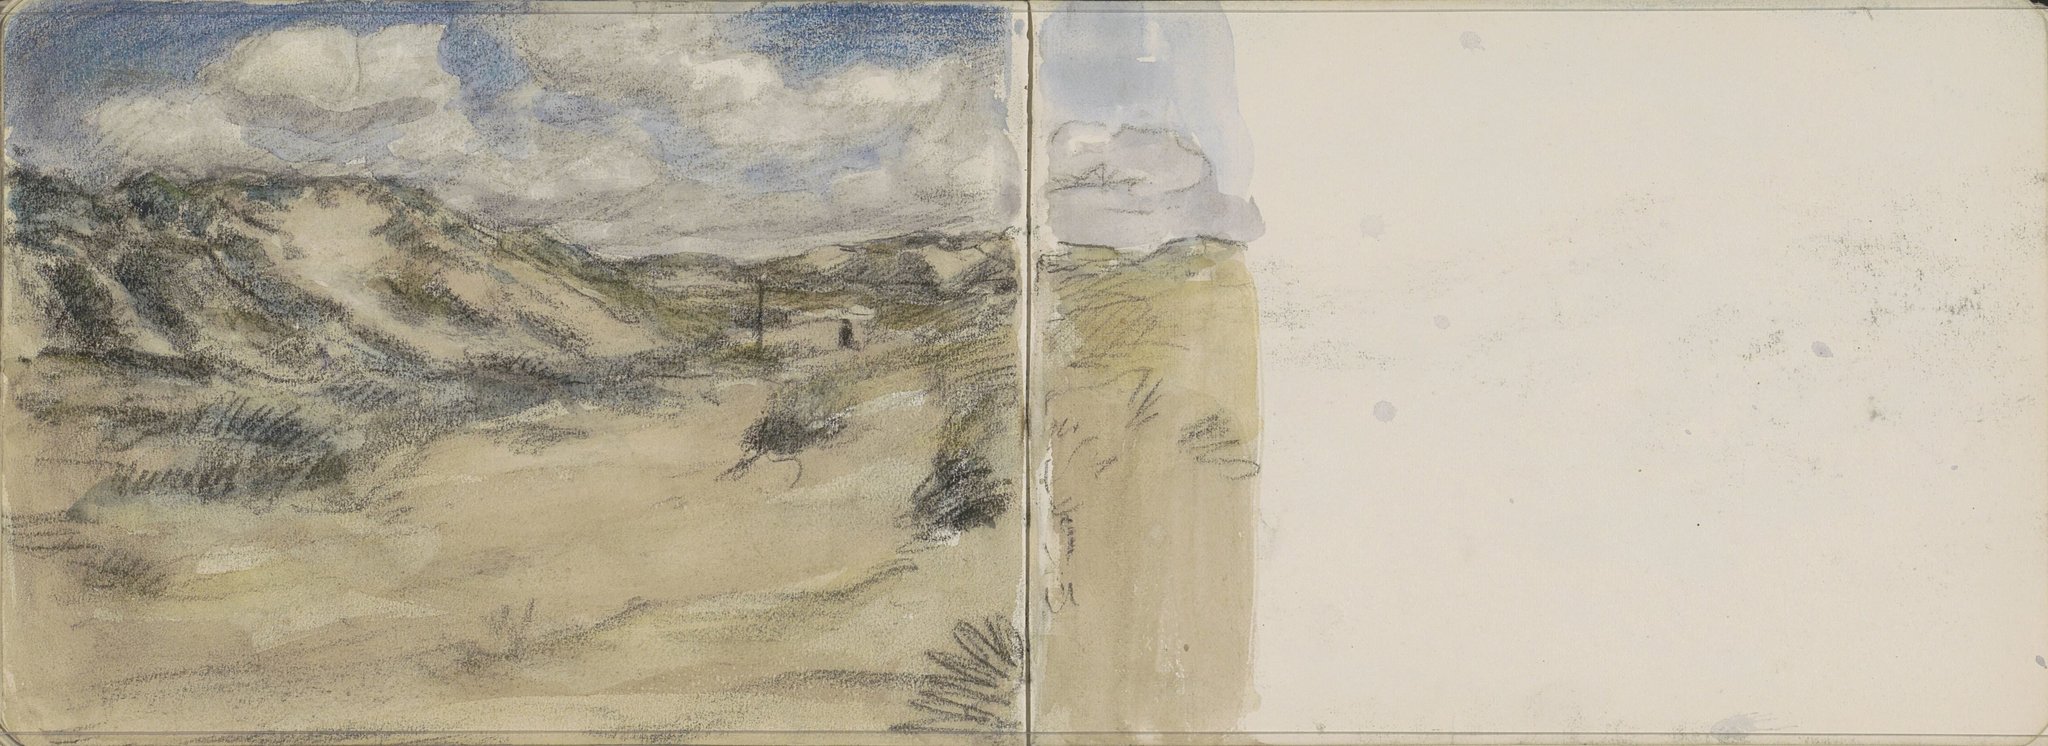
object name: sketchbook leaf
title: Duinlandschap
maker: johan antonie de jonge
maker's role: draughtsman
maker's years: 1864-1927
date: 1881-1927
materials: chalk, paper, watercolor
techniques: stumping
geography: south holland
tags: dunes (sea not visible); in the dunes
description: Duinlandschap. Blad 18 verso en blad 19 recto uit een schetsboek met 28 bladen.